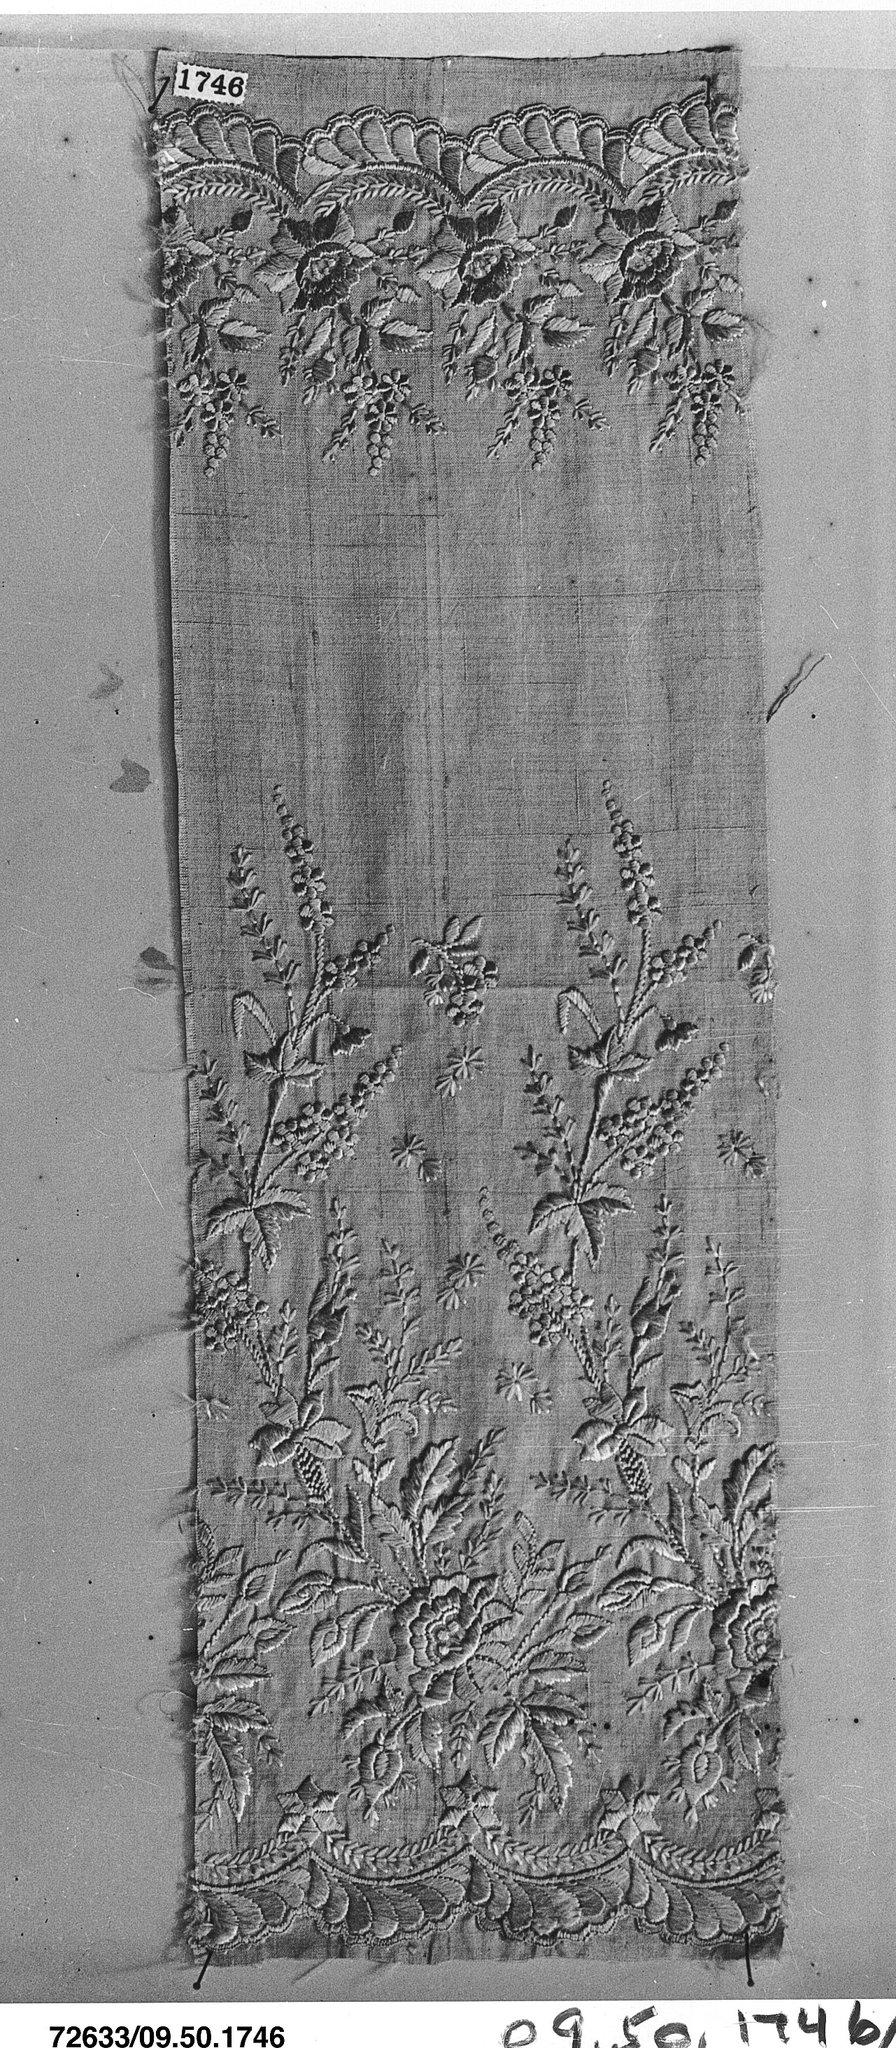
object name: fragment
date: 1801-1900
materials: silk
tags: flowers,leaves